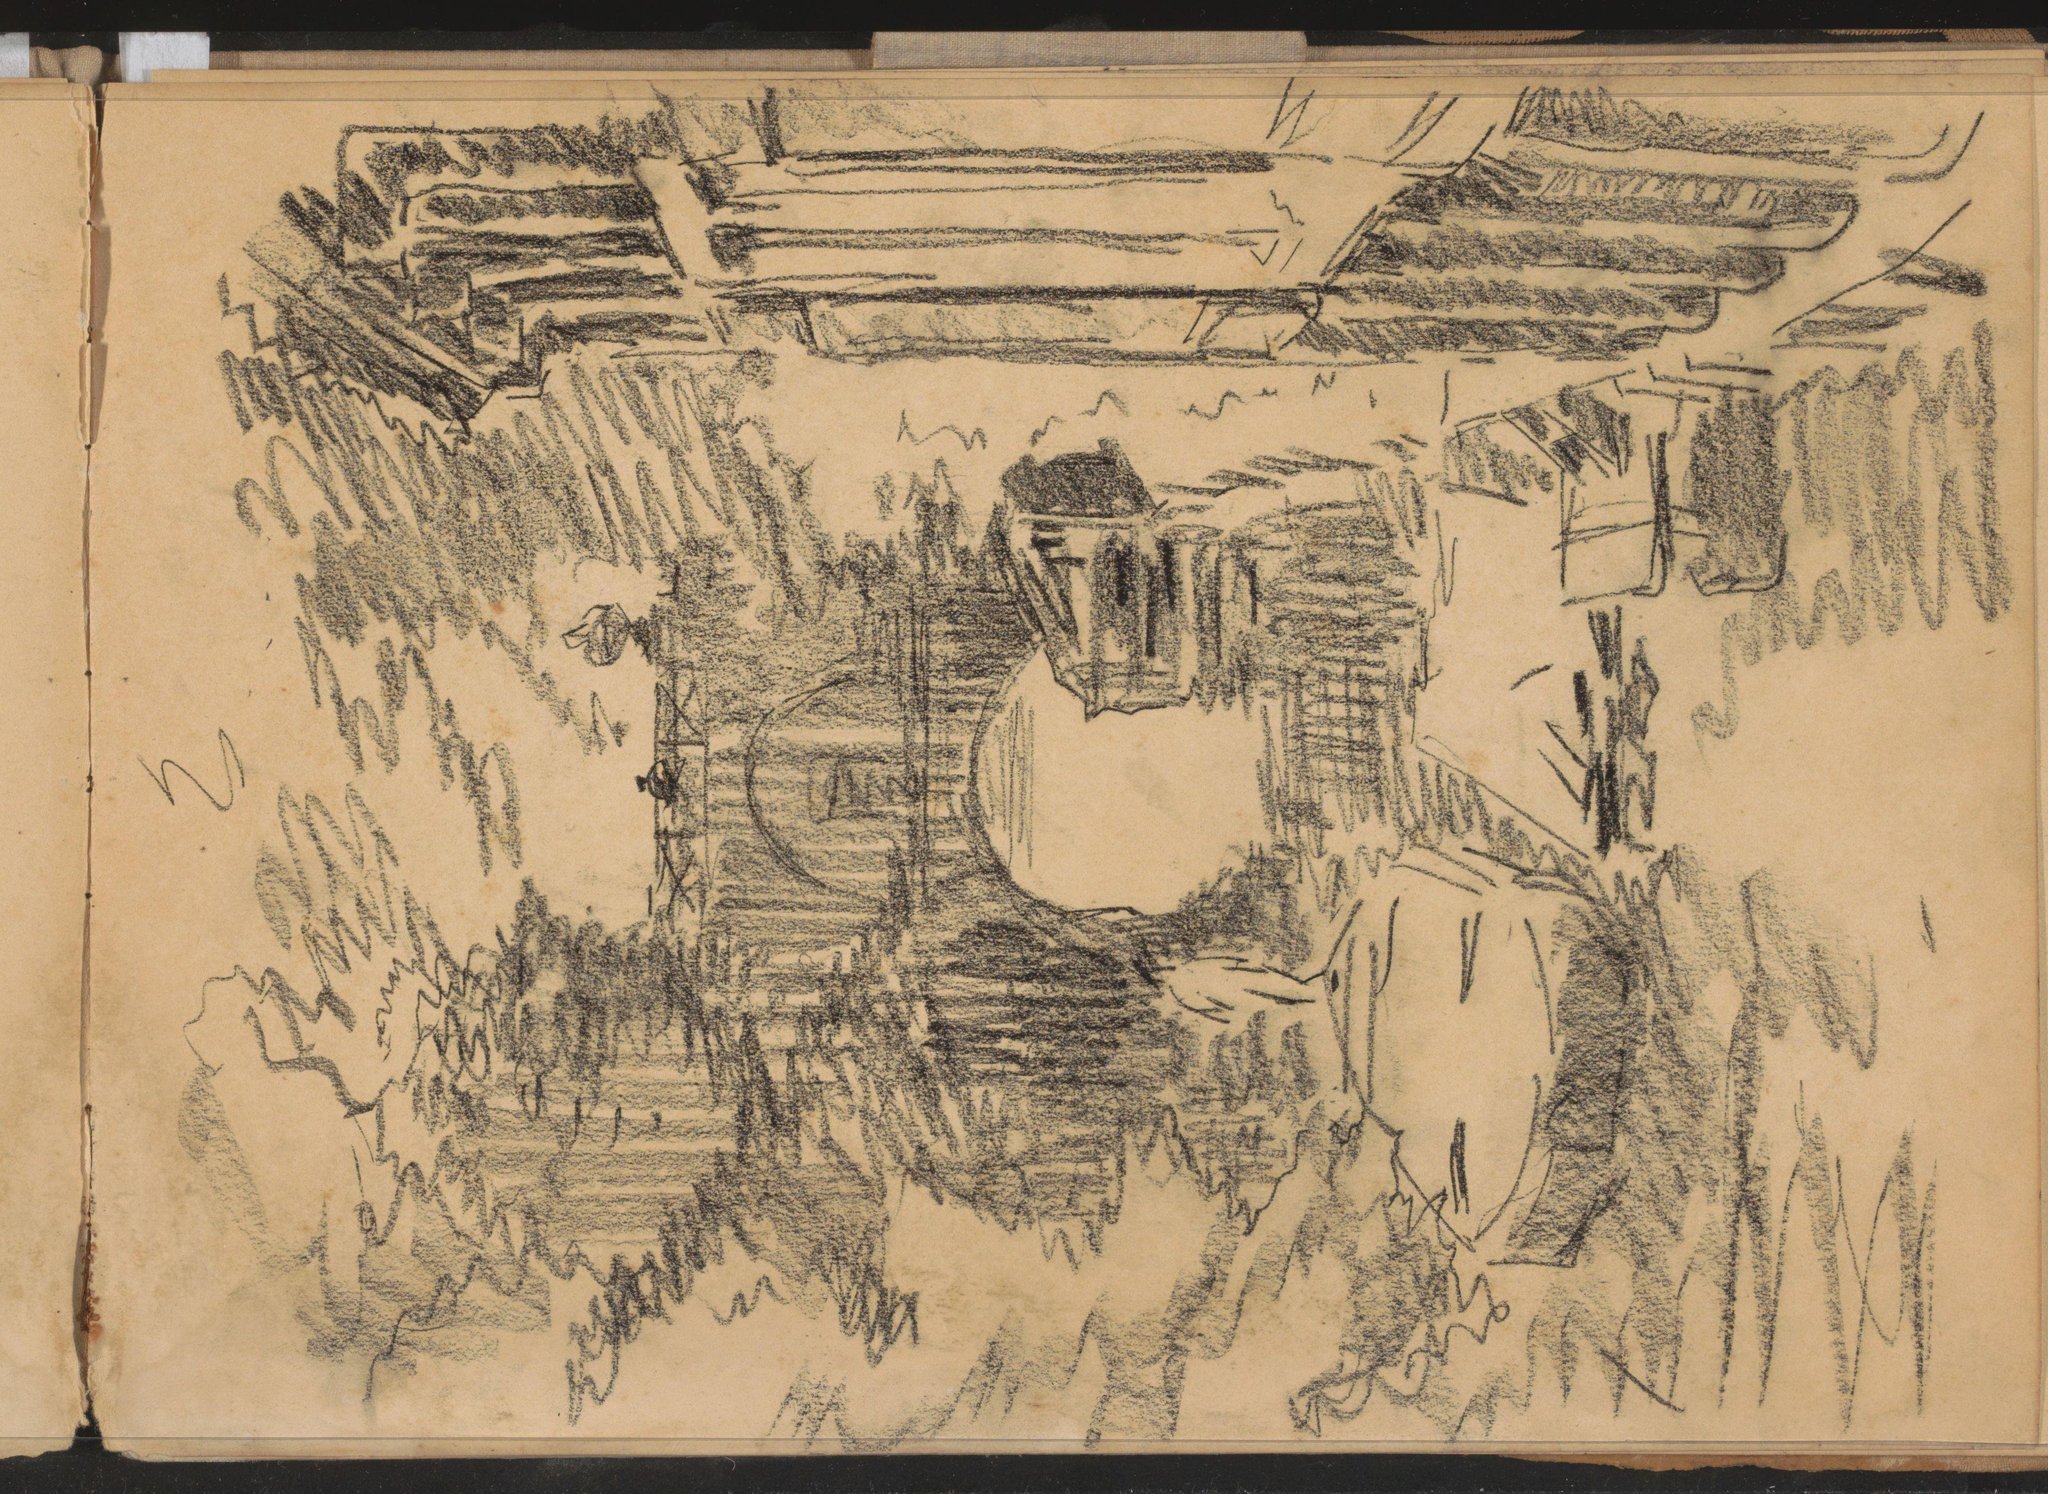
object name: sketchbook leaf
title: Figuur op een brug over een rivier in een boomrijke omgeving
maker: willem bastiaan tholen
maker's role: draughtsman, painter, print maker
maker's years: 1860-1931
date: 1885-1931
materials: chalk, paper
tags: trees, river, rural housing, e.g. country-house, villa, cottage, rowing-boat, canoe, etc., bridge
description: Blad 10 recto uit een schetsboek met 28 bladen.